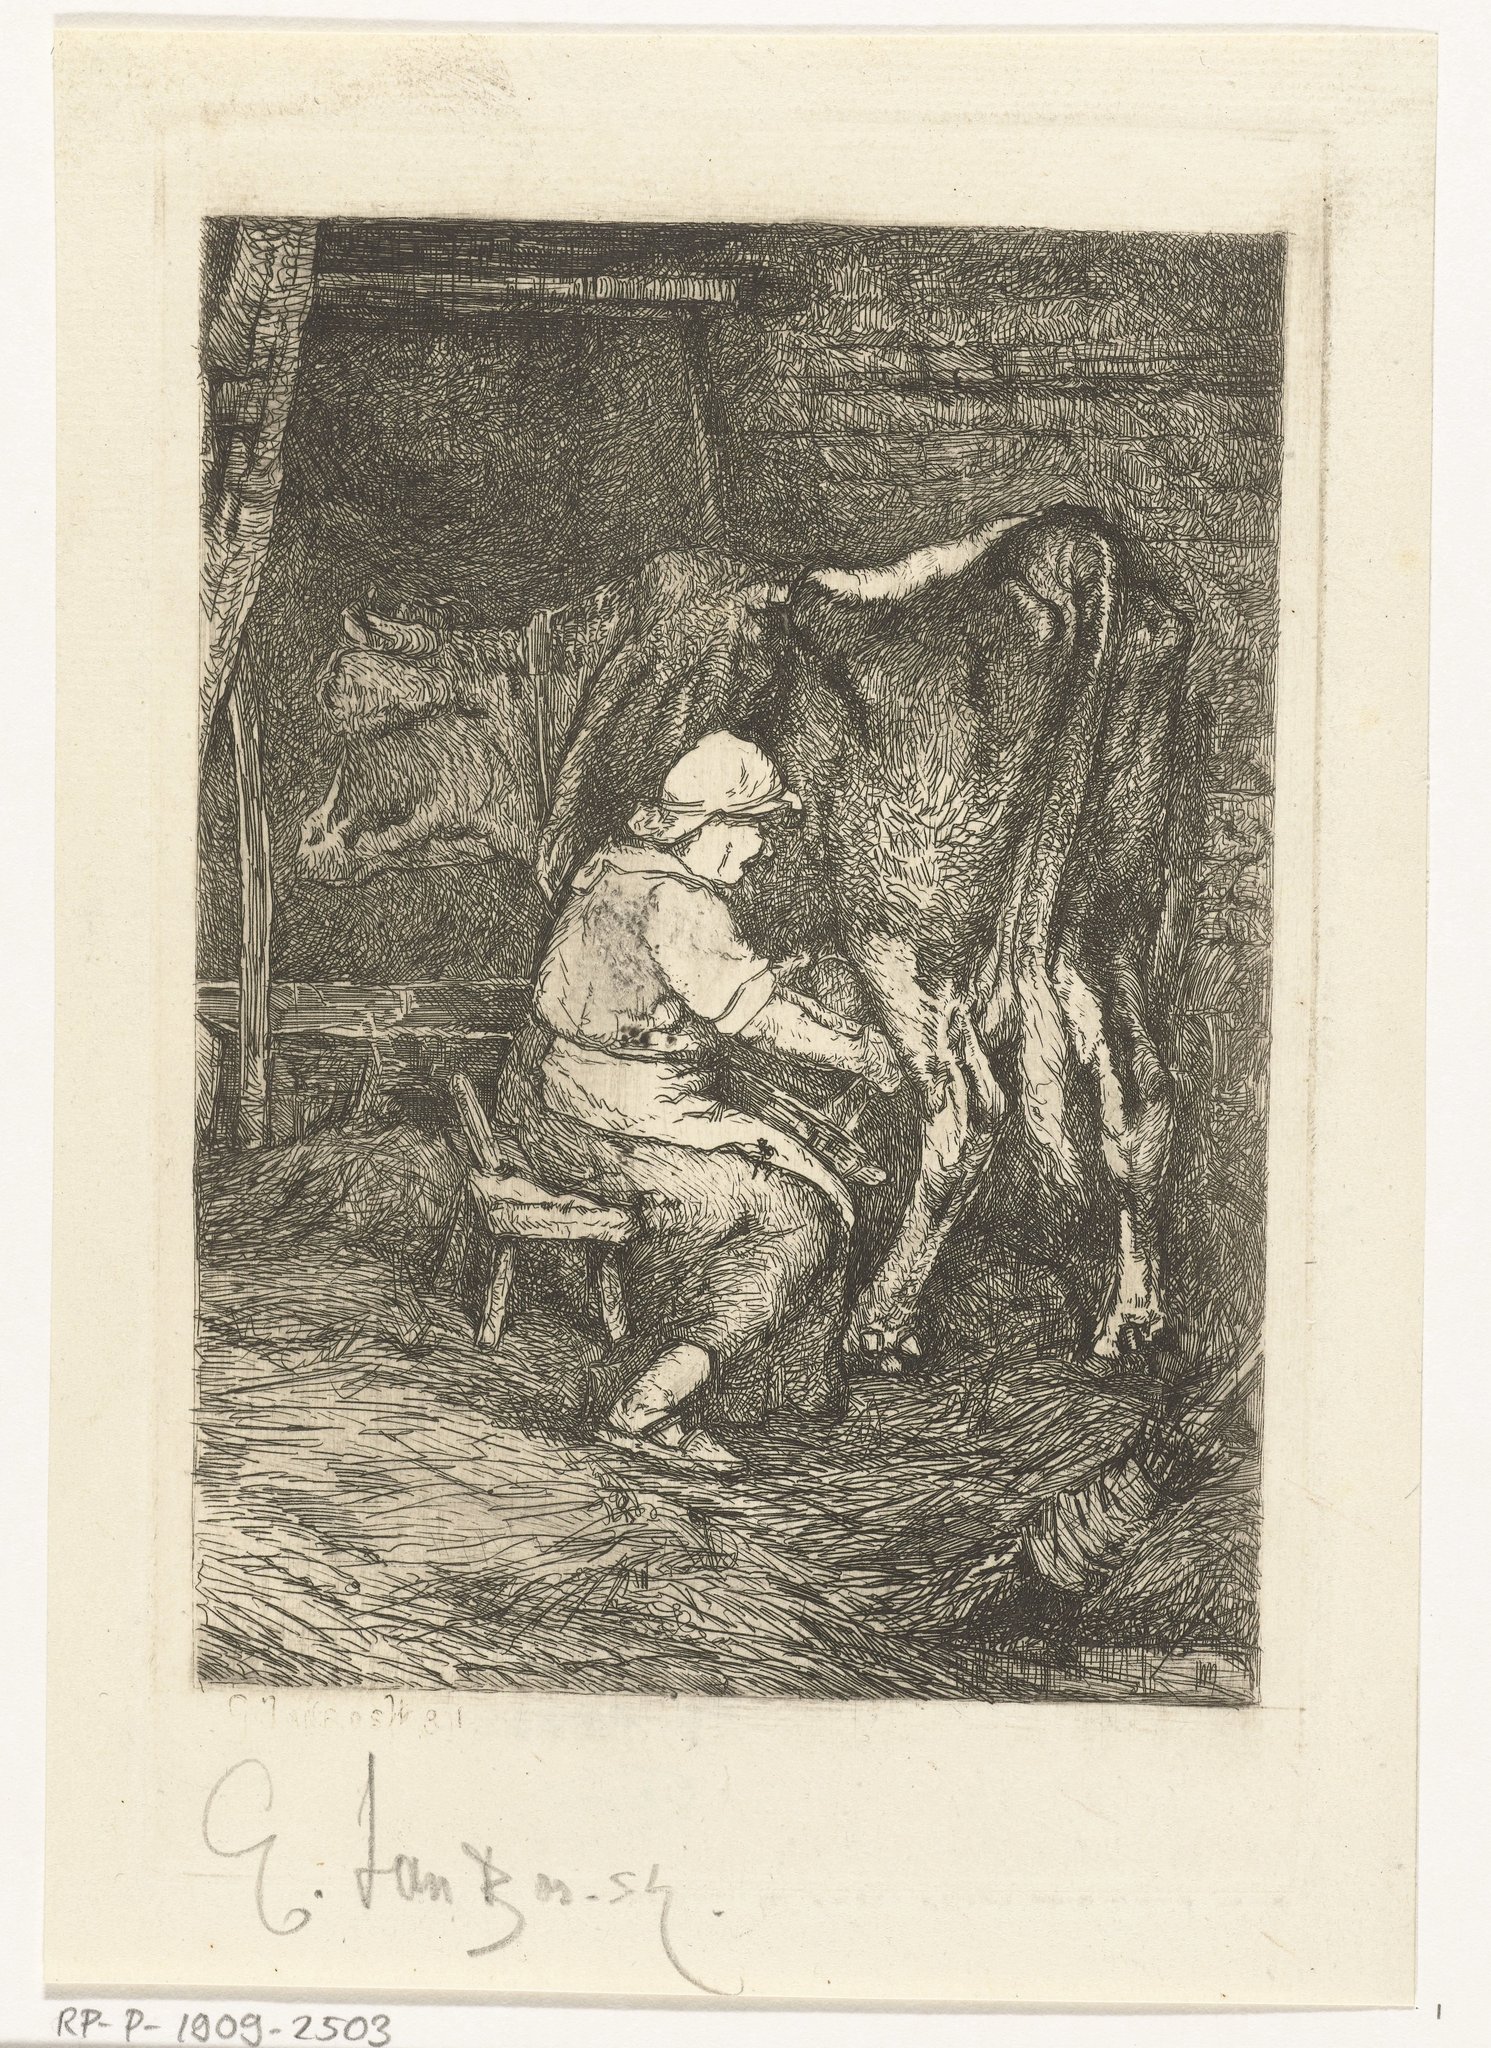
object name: print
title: Een koe wordt in de stal gemolken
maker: gerard jan bos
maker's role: print maker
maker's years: 1860-1943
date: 1884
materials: paper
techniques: etching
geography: antwerp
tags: milking (+ indoors; in laboratory, factory, barn, etc.)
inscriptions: collector's mark: Lugt 2228, signature: ‘G. Jan Bos sc.’